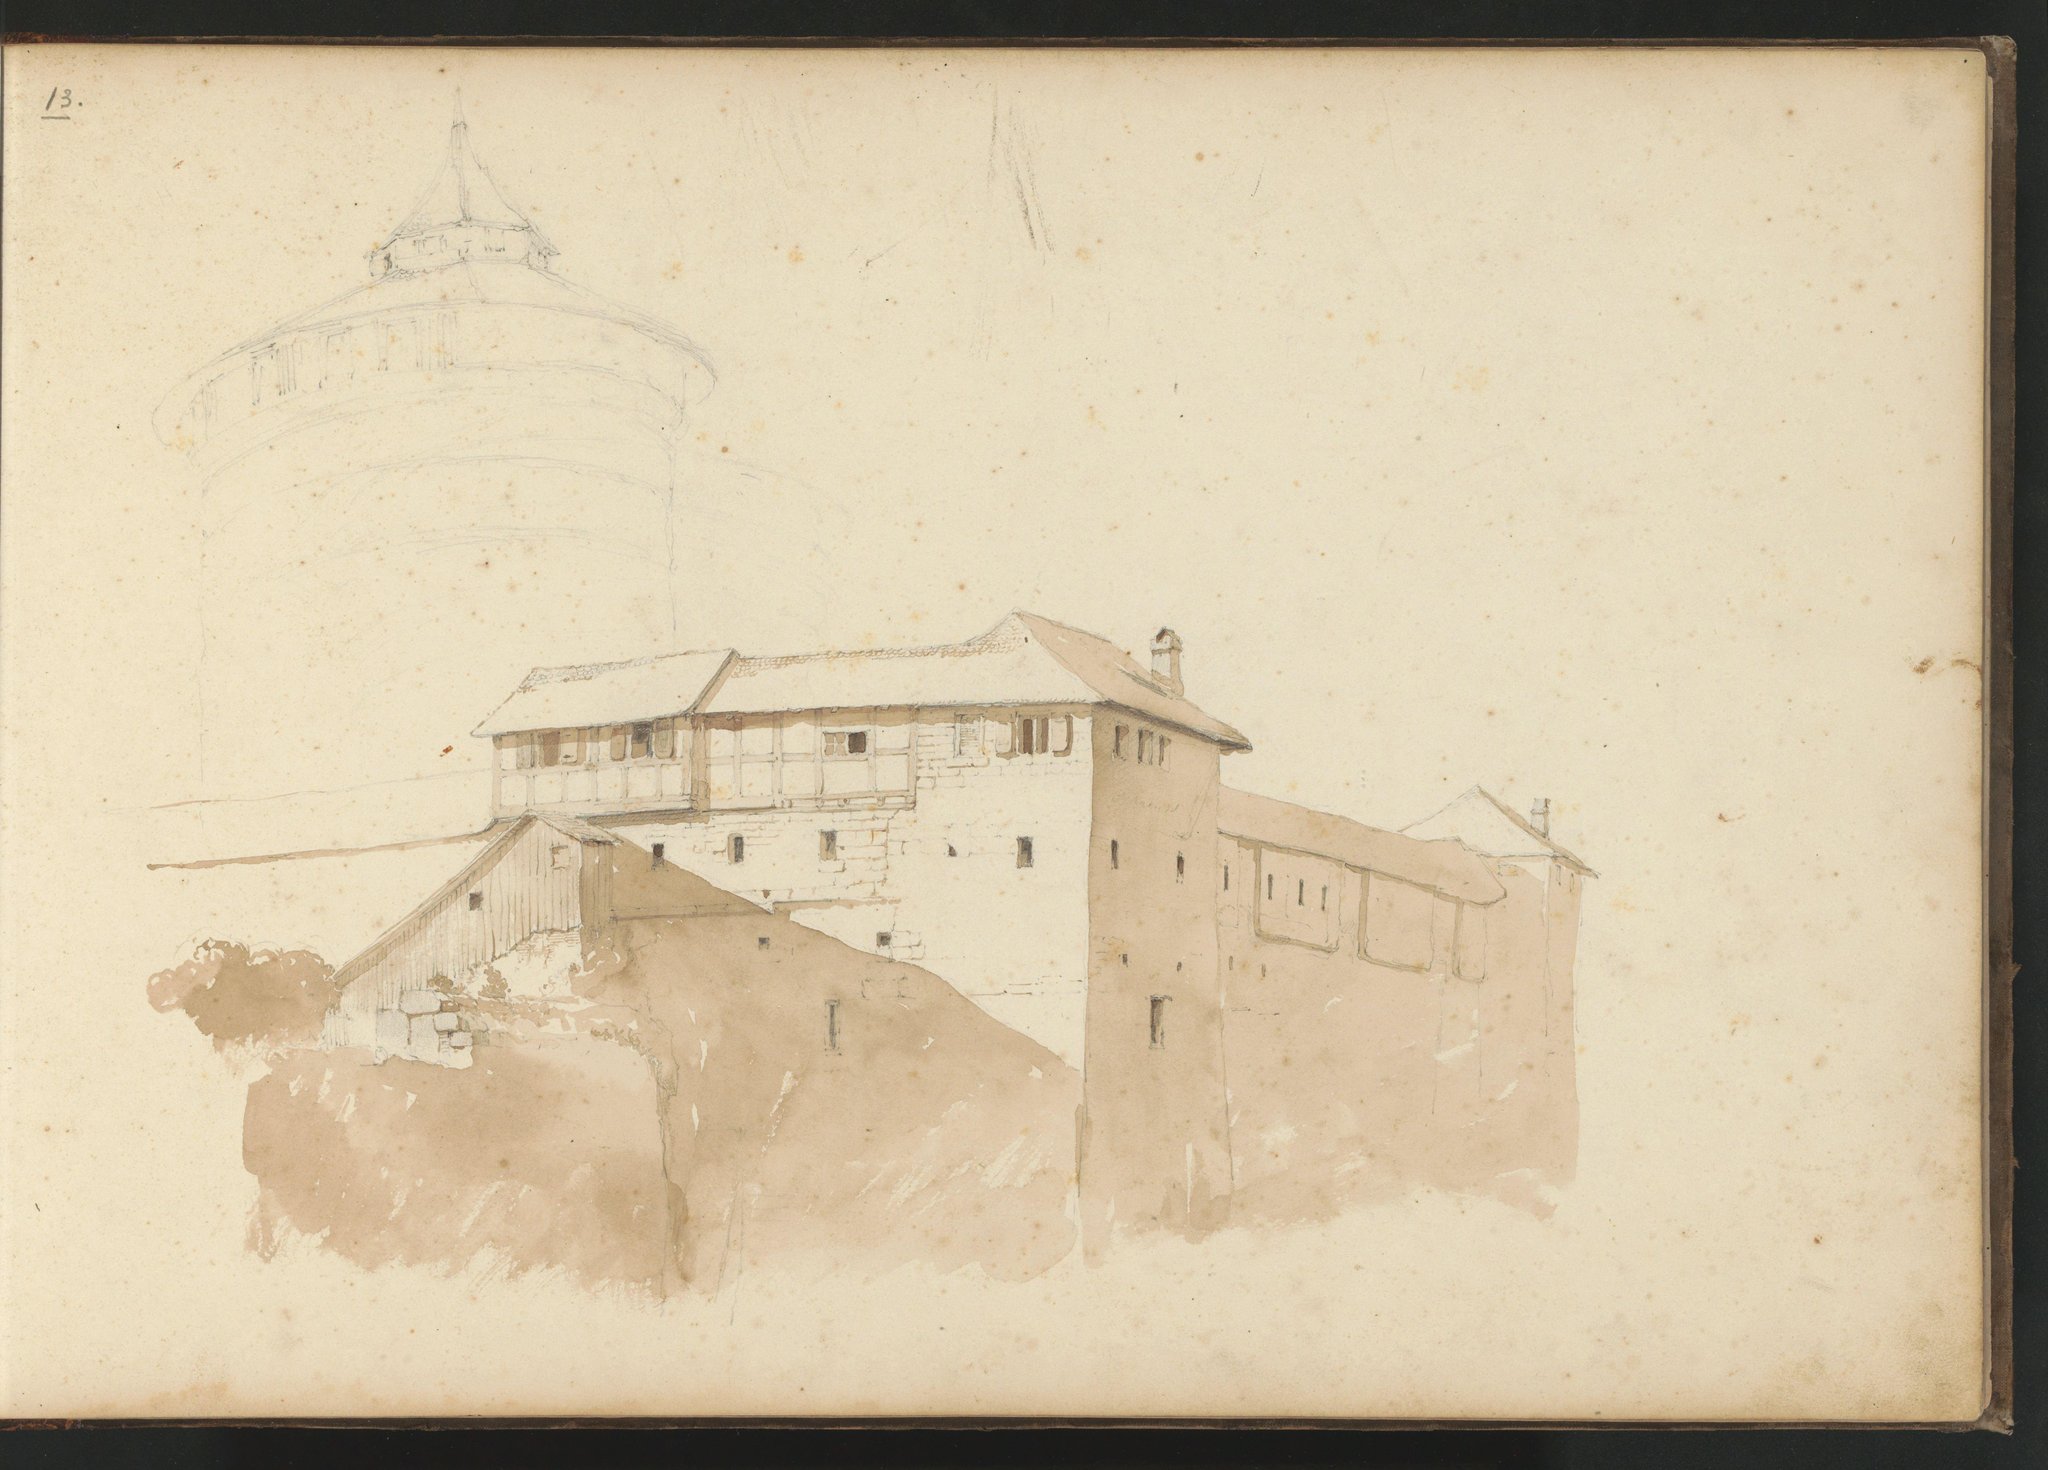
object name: sketchbook leaf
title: Toren en een gebouw met een vakwerkgevel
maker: kasparus karsen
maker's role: draughtsman, painter, print maker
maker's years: 1810-1896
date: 1820-1896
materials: paper, pencil, watercolor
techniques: brush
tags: architecture, tower (of house or building)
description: Blad 13 recto uit een schetsboek met 68 bladen.